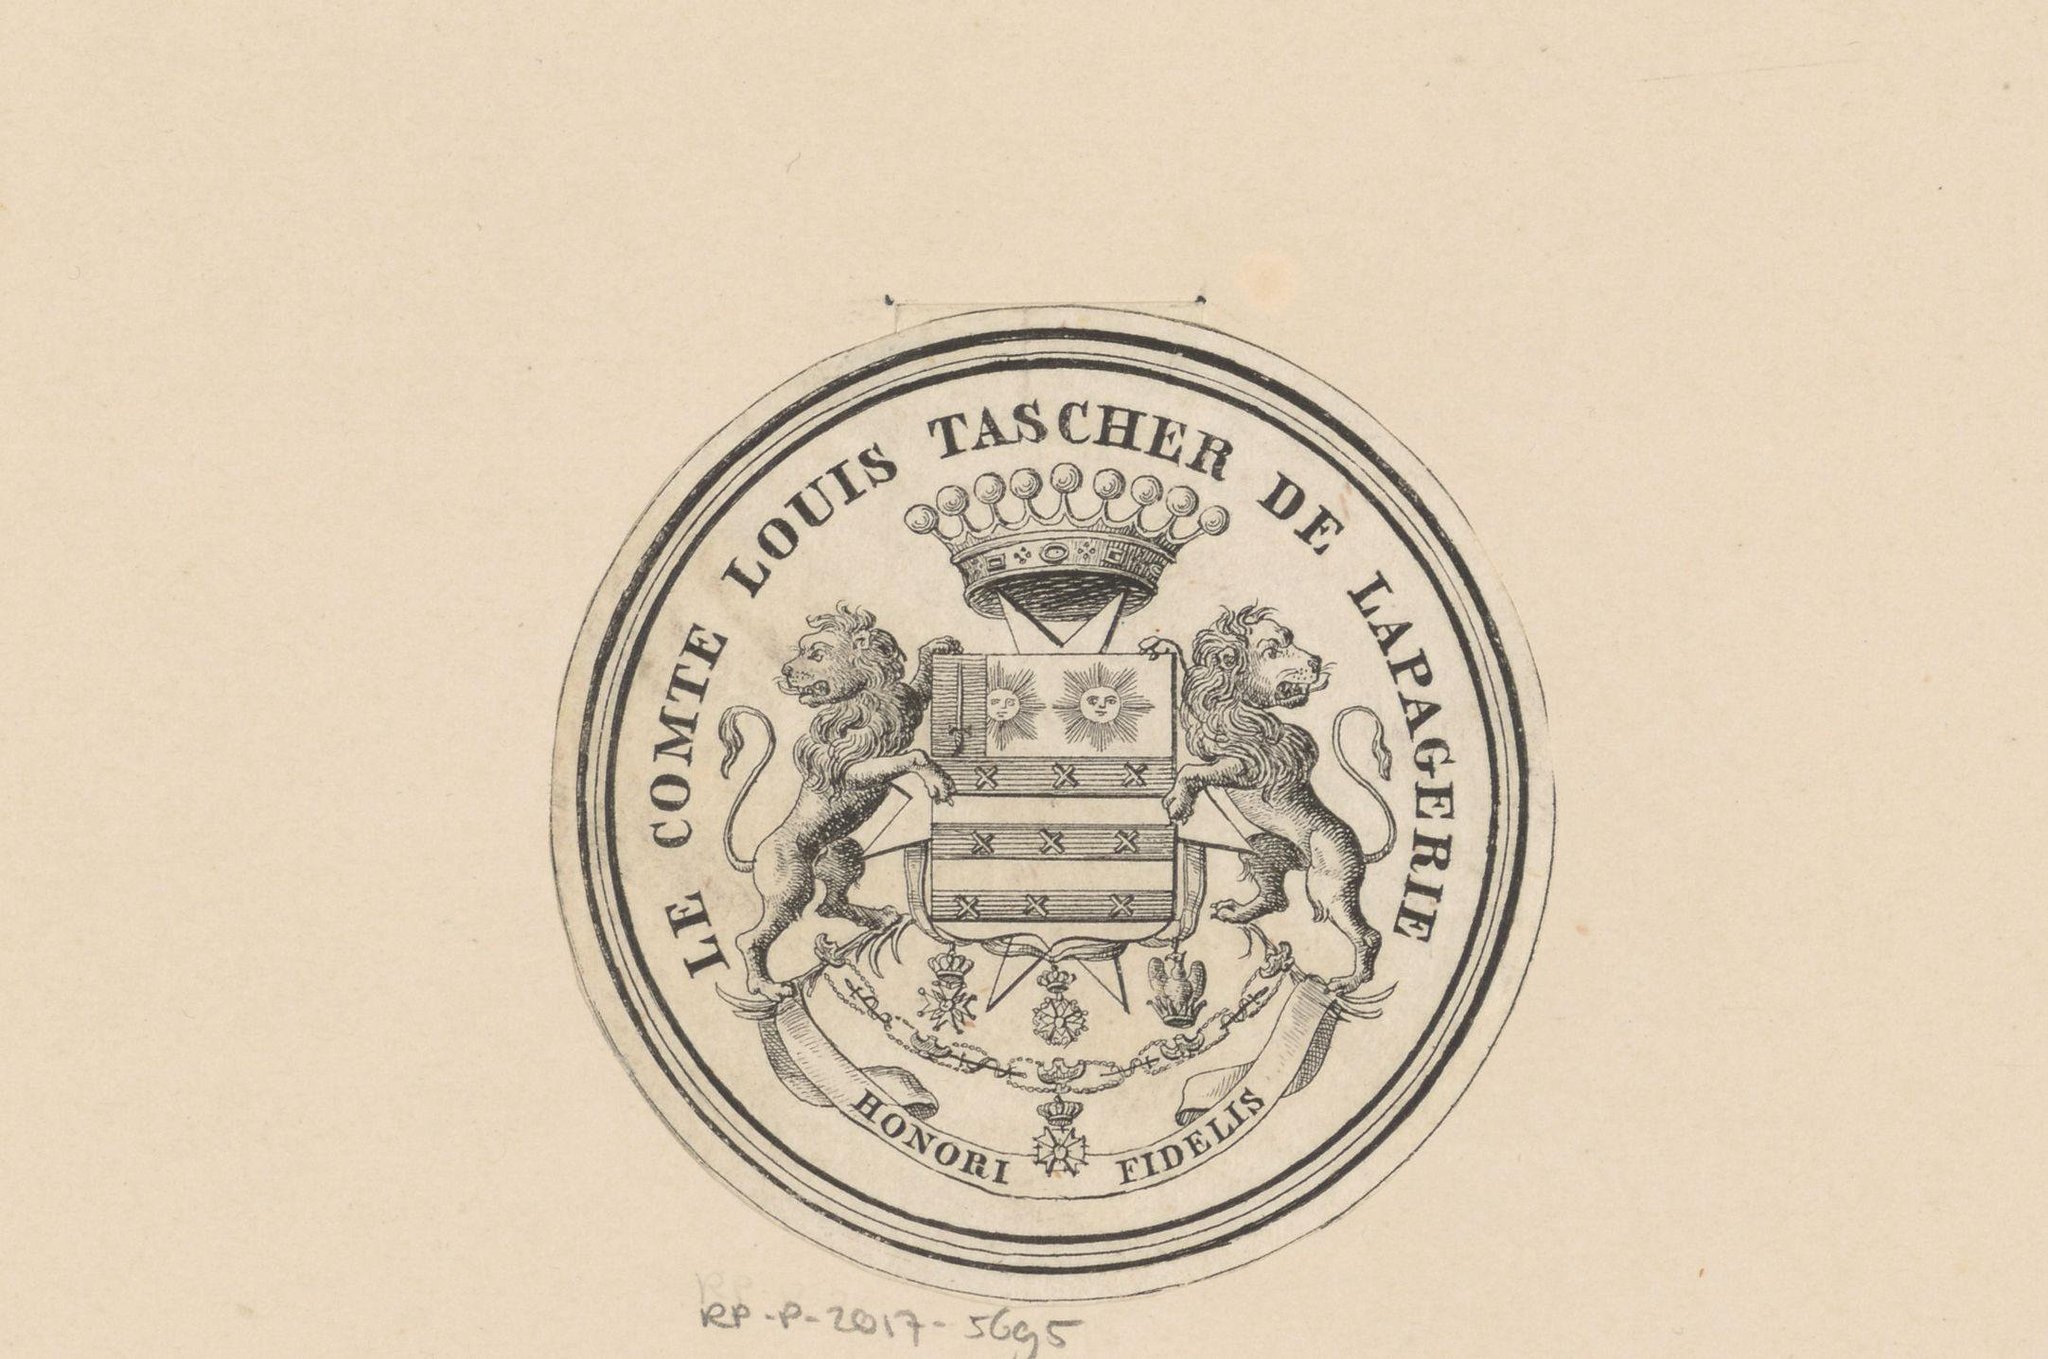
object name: bookplate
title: Ex libris van le Comte Louis Tascher de La Pagerie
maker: Anonymous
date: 1797-1861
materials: paper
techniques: etching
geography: france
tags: politician, armorial bearing, heraldry